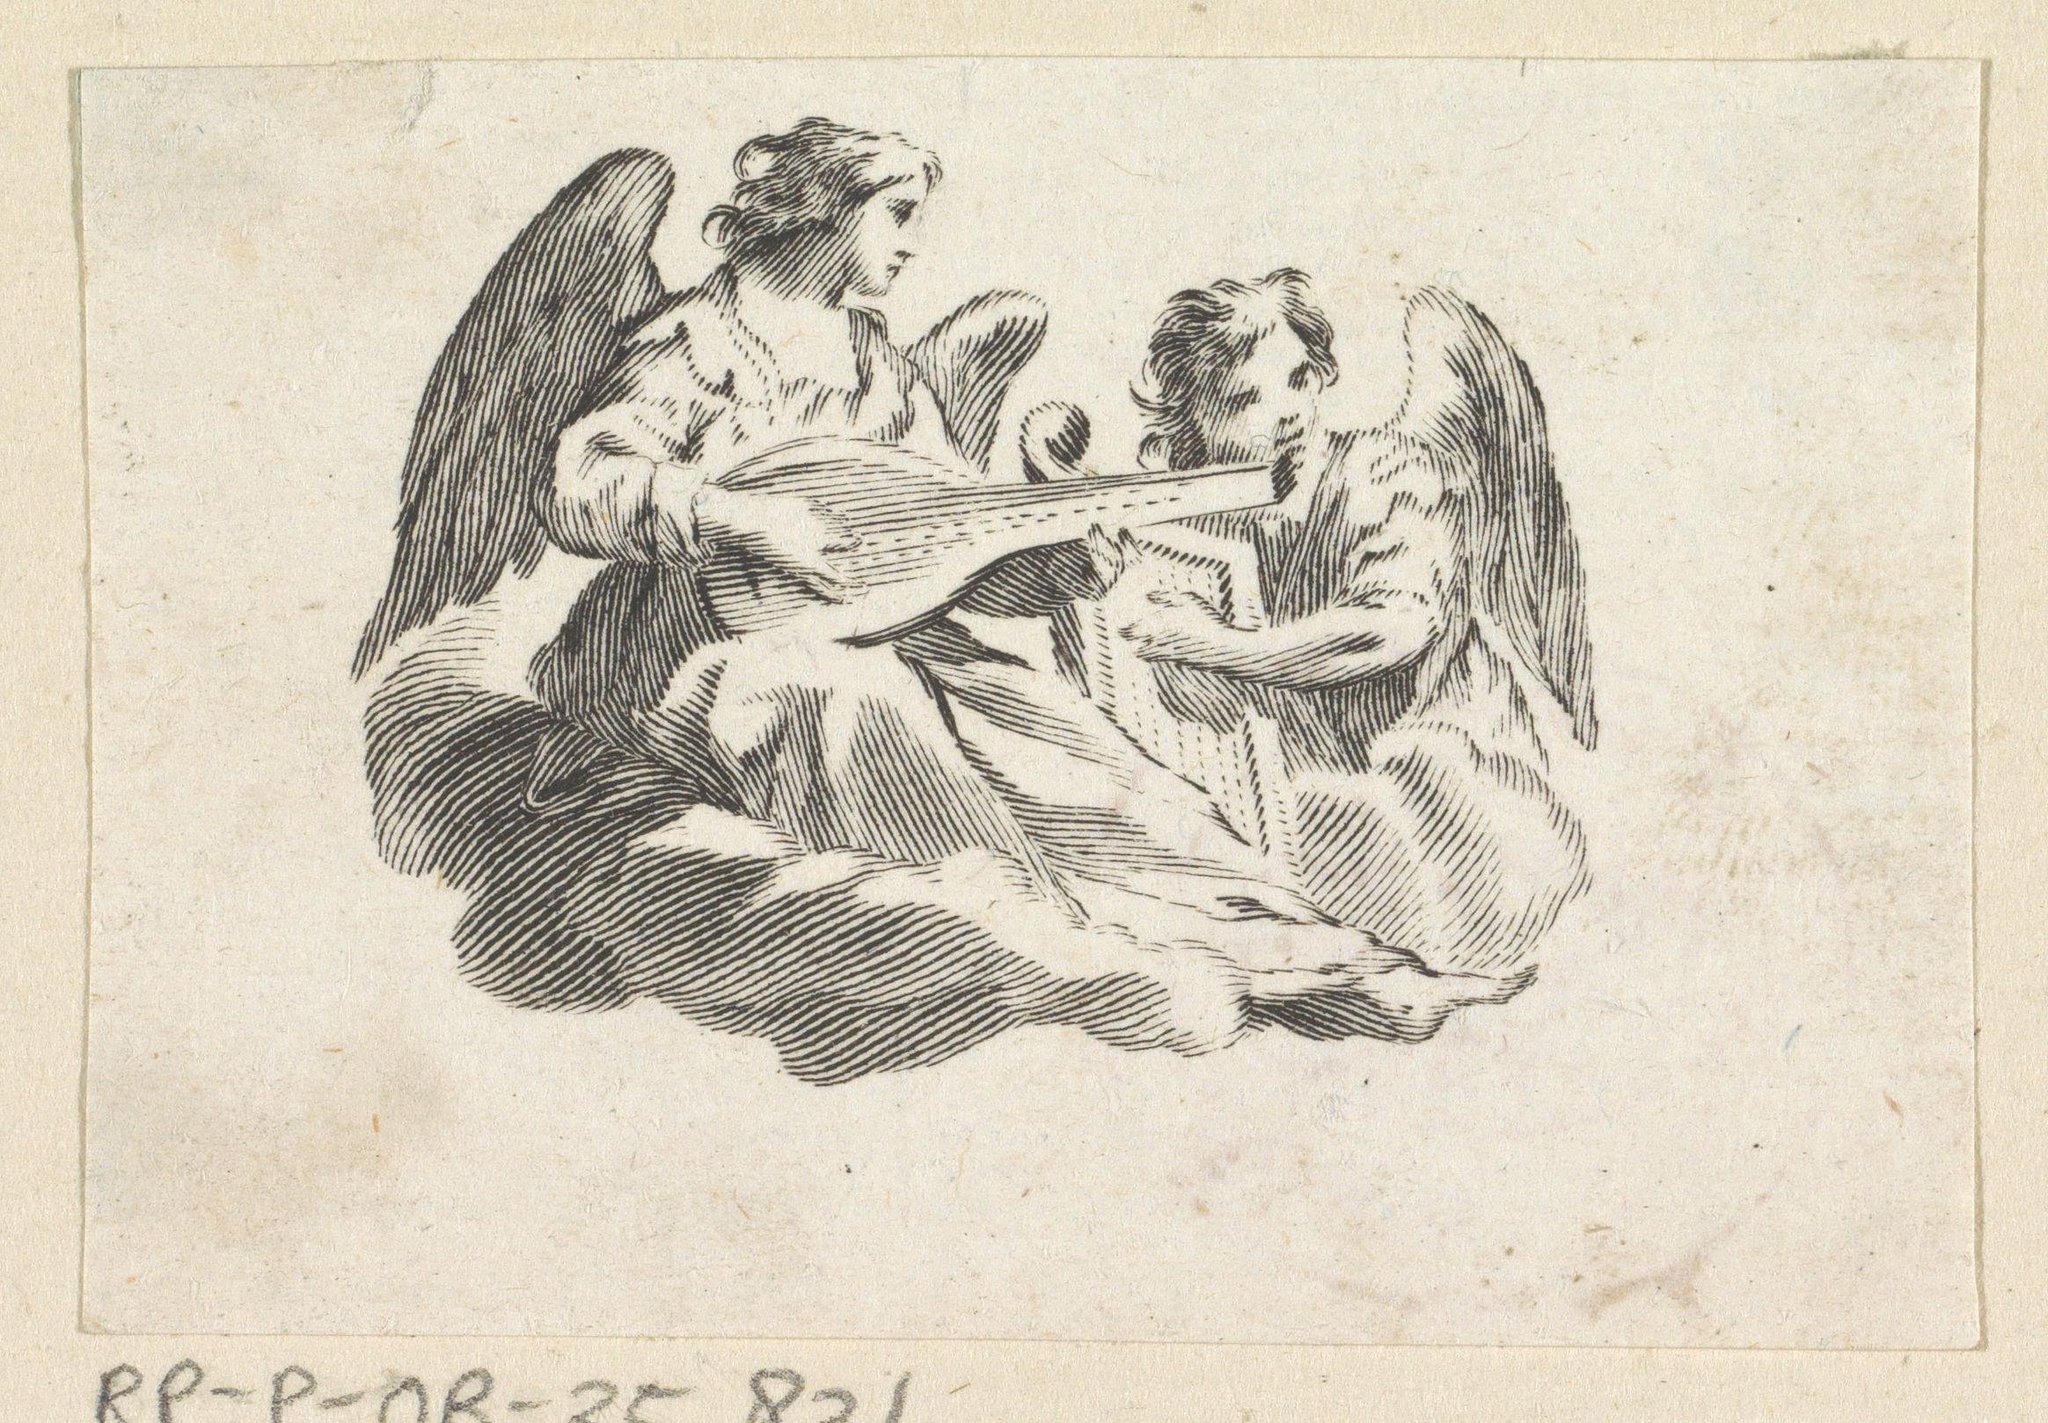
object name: print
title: Twee musicerende engelen met luit en lier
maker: giovanni cattini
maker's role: print maker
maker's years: 1725-1800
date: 1735-1800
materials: paper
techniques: engraving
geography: italy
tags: lyre, cithara, psaltery, angels singing, making music, lute, and special forms of lute, e.g.: theorbo, angels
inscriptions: collector's mark: Lugt 240